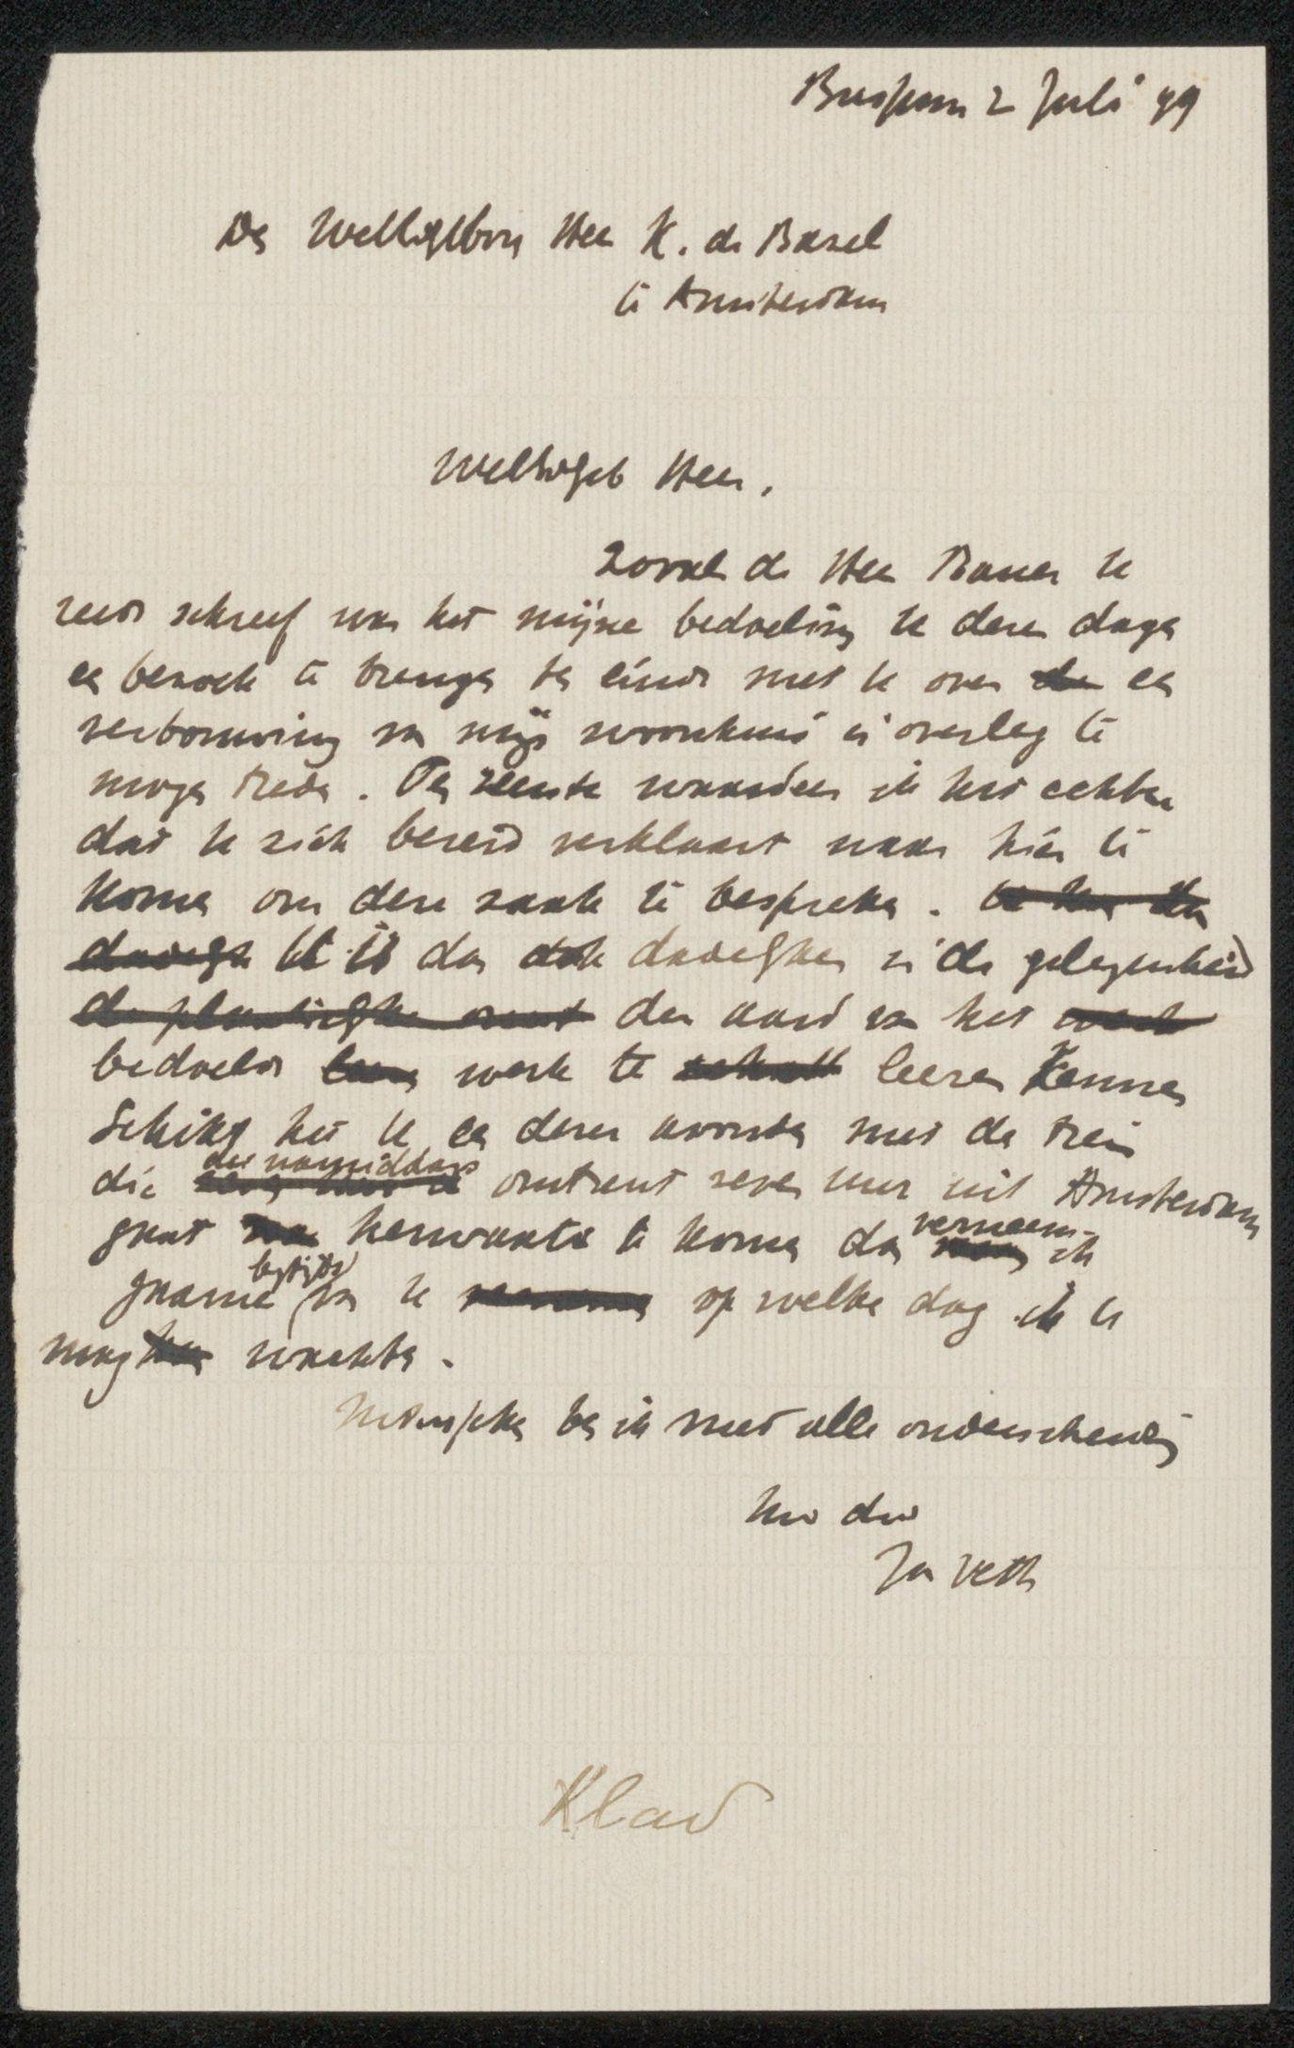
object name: letter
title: Brief aan Karel Petrus Cornelis de Bazel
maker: jan veth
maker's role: designer, draughtsman, painter, print maker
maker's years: 1864-1925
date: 1899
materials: ink, paper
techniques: pen, writing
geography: bussum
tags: den helder, karel petrus cornelis de bazel, the hague, wilhelm cornelis bauer, architecture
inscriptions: collector's mark: ‘RPK’